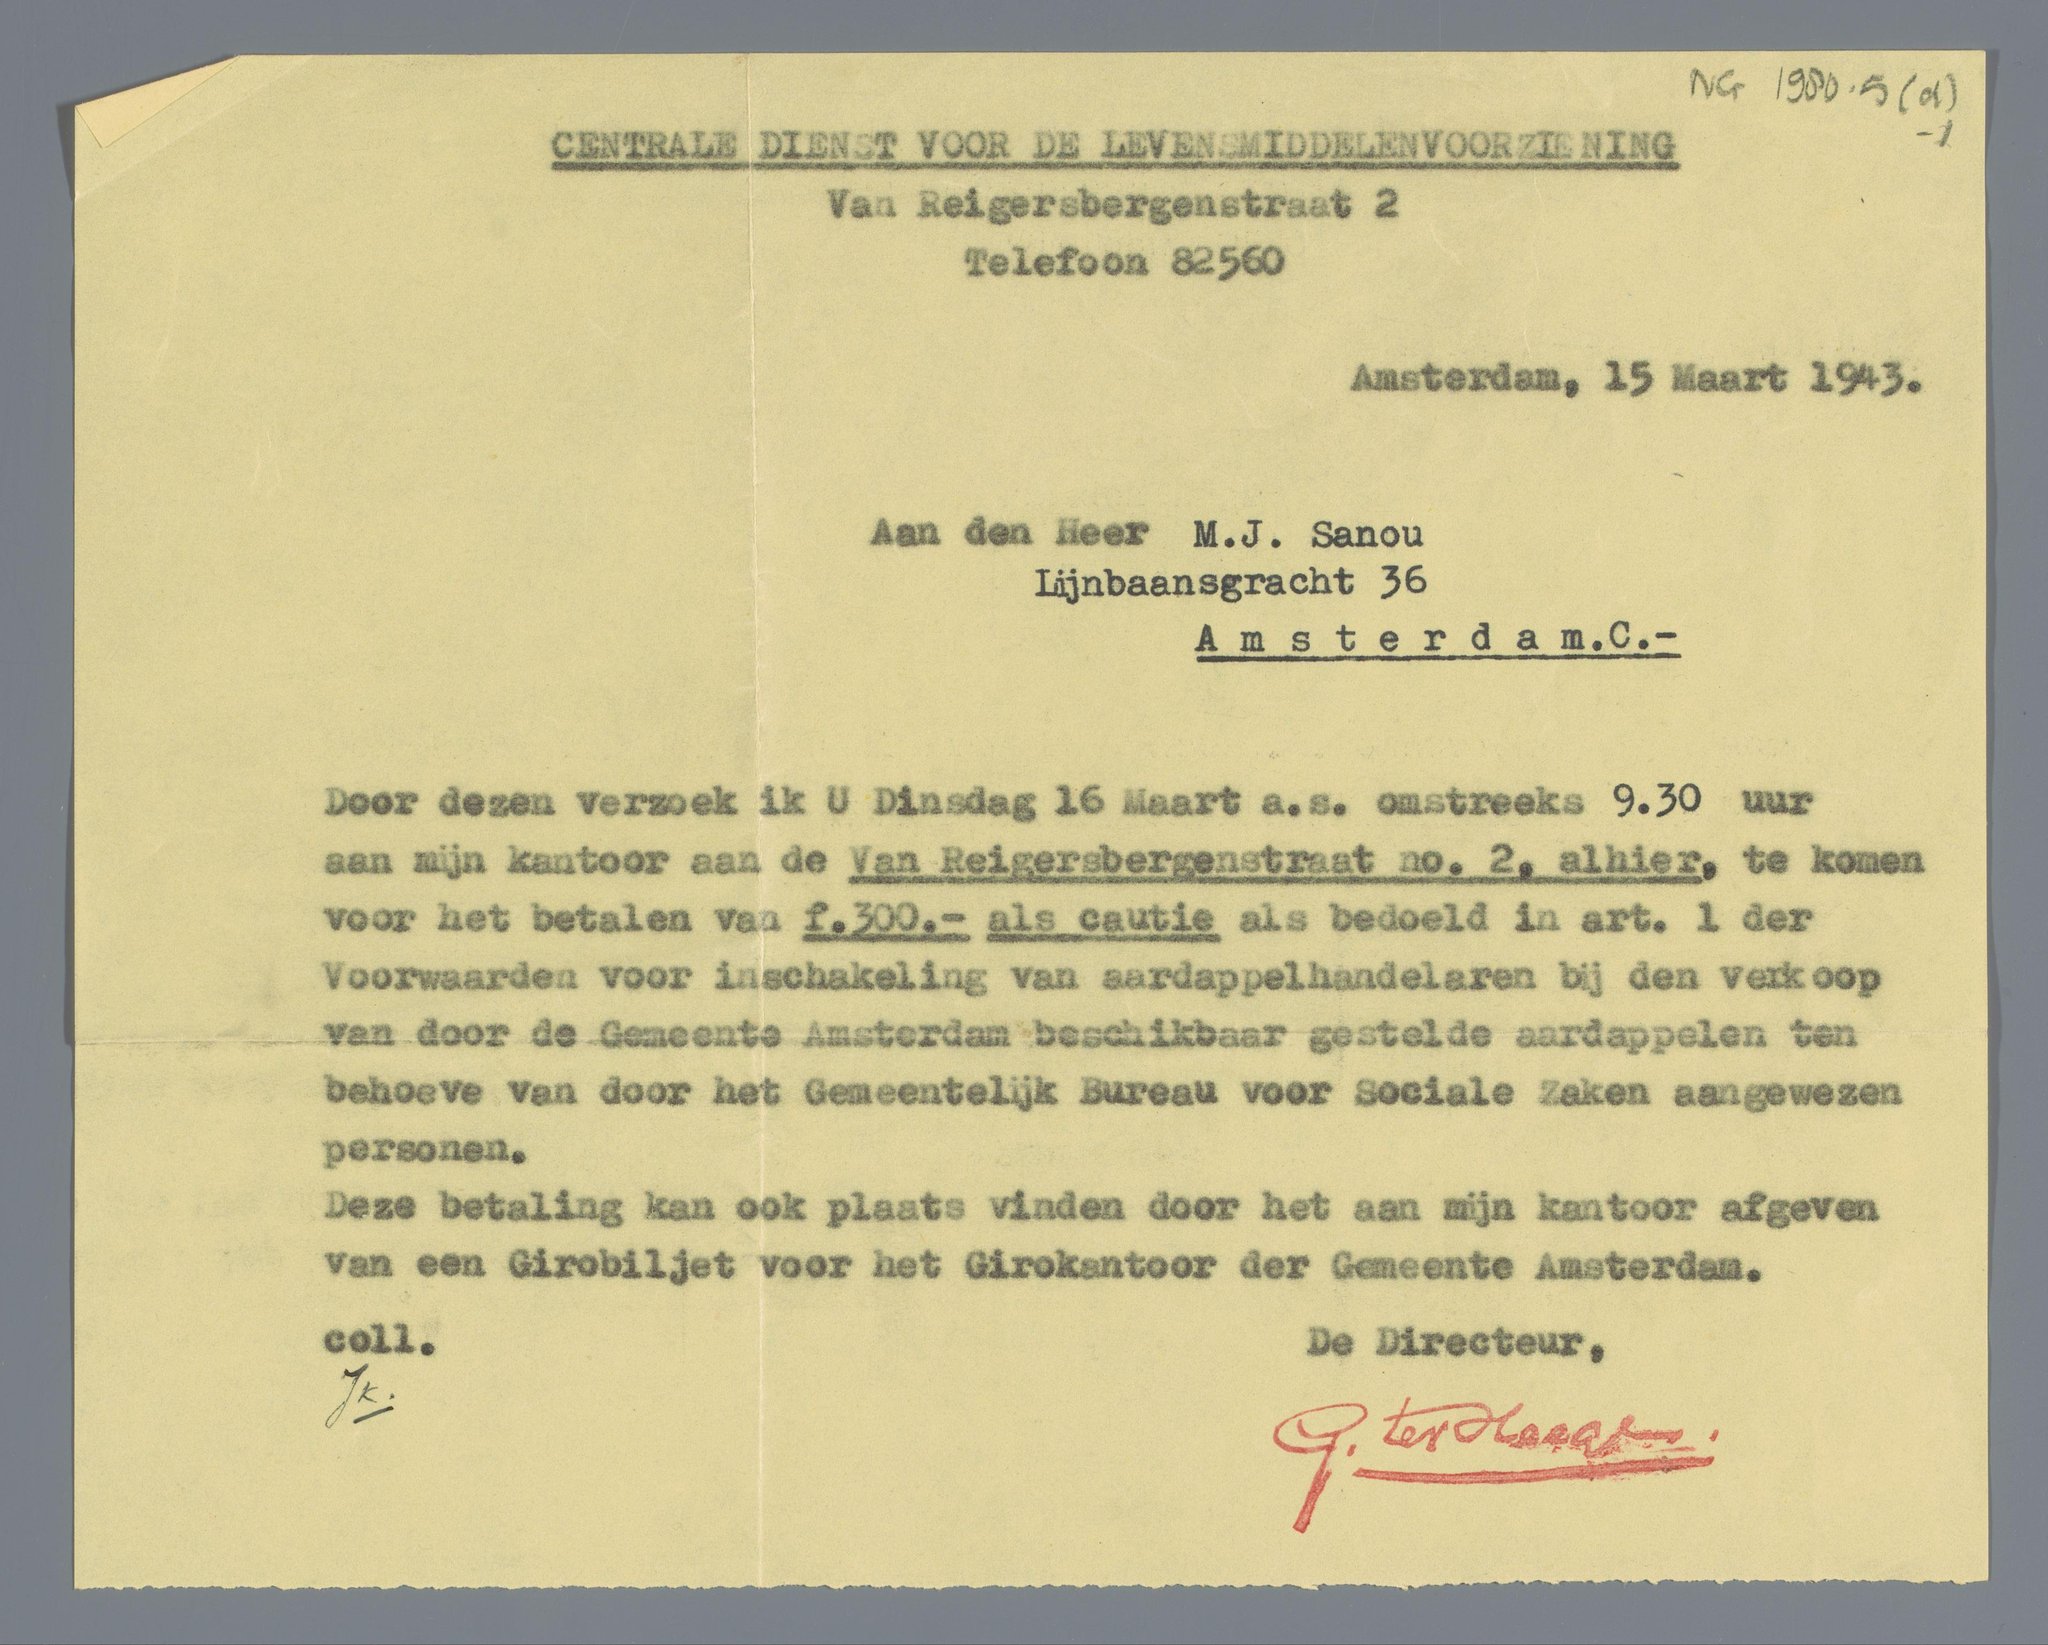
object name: document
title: Document gericht aan M.J. Sanou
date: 1943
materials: ink, paper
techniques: printing, typewriting, writing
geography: amsterdam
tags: netherlands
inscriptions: date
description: Een brief gericht aan M.J. Sanou, verband houdende met het betalen van f300,00 als cautie vanwege zijn beroep als aardappelhandelaar. Gesigneerd en gedateerd.